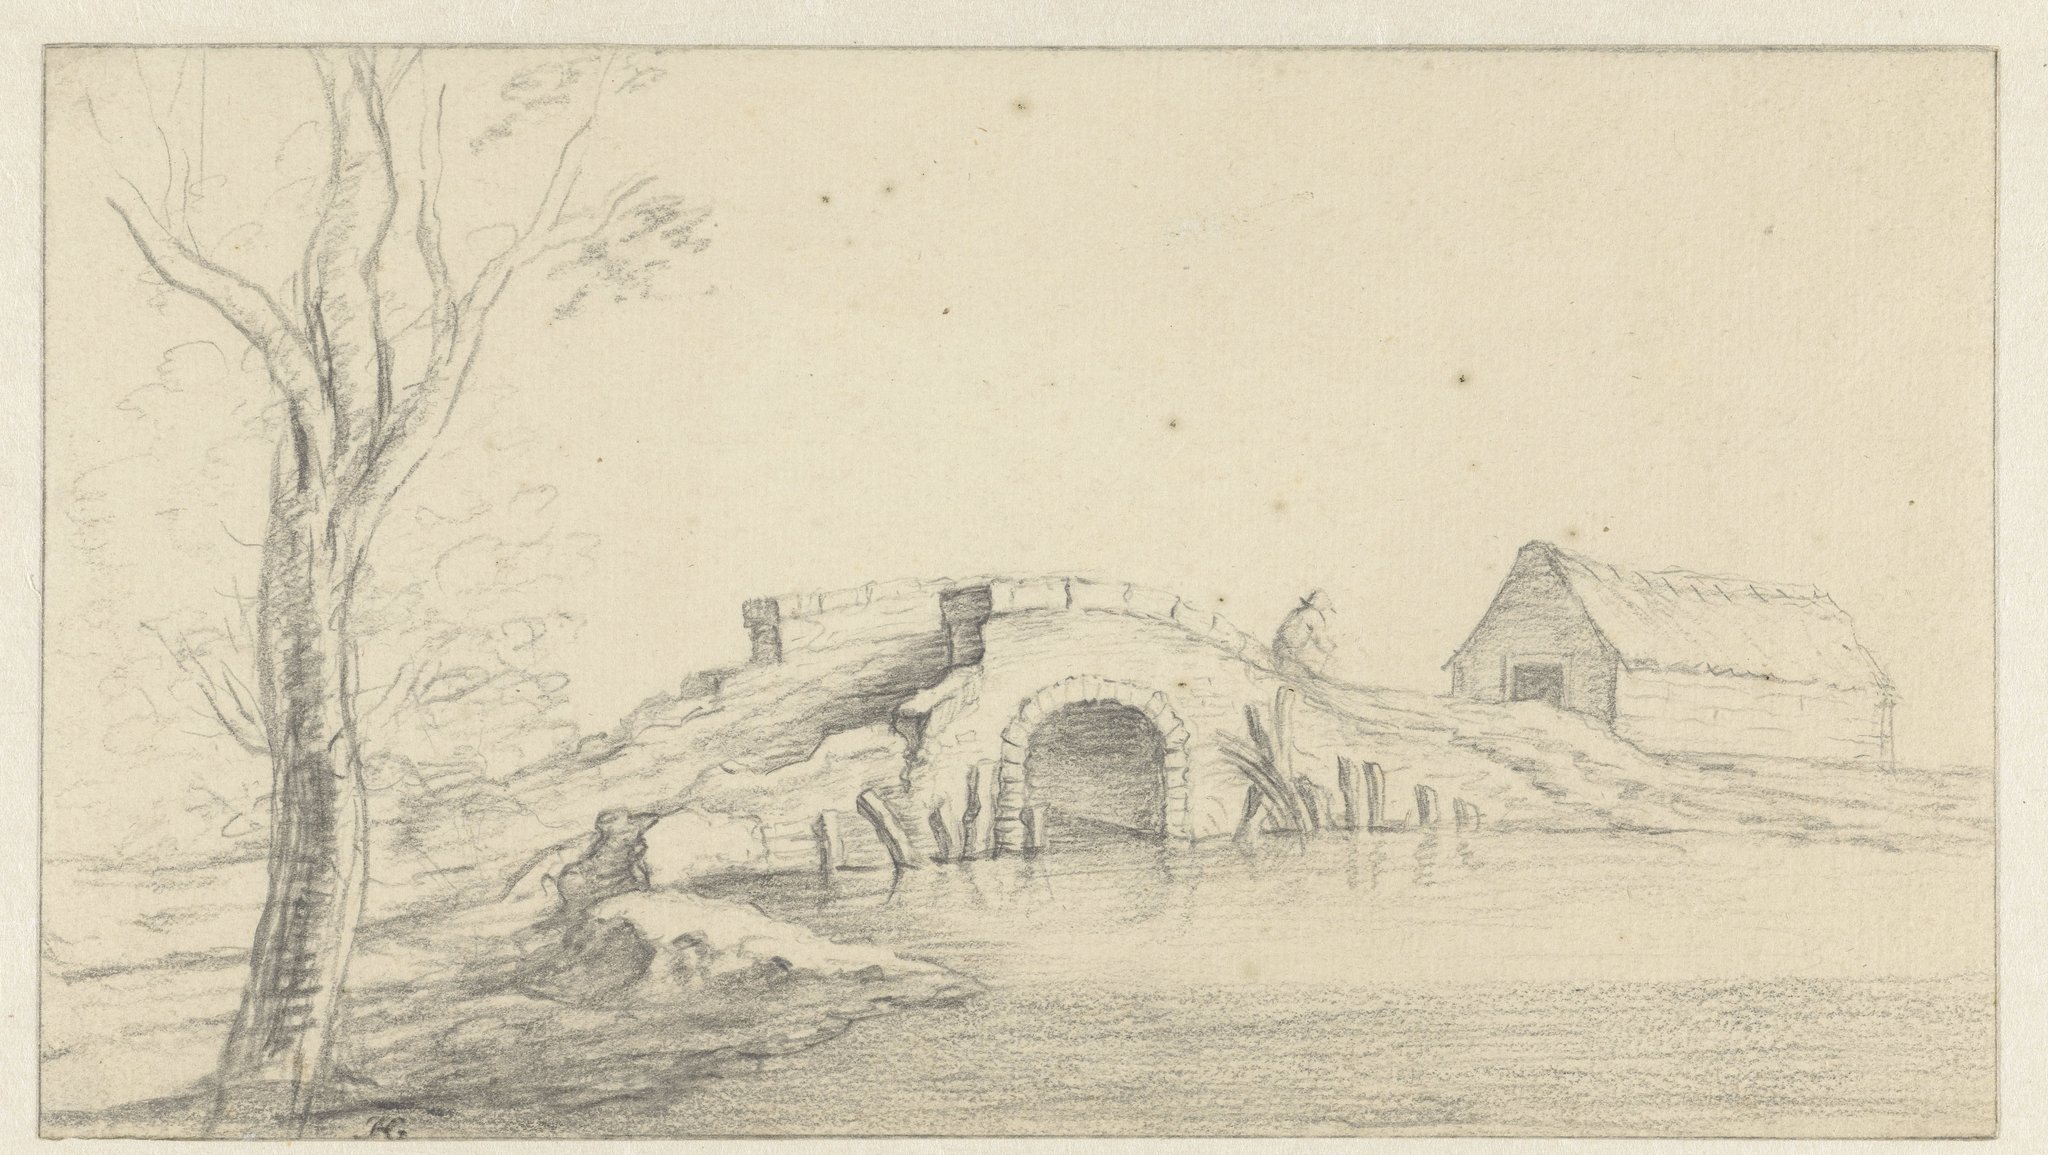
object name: drawing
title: Landschap met vervallen stenen brug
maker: hendrik chalon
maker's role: draughtsman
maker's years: -1790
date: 1700-1790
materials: chalk, paper, pencil